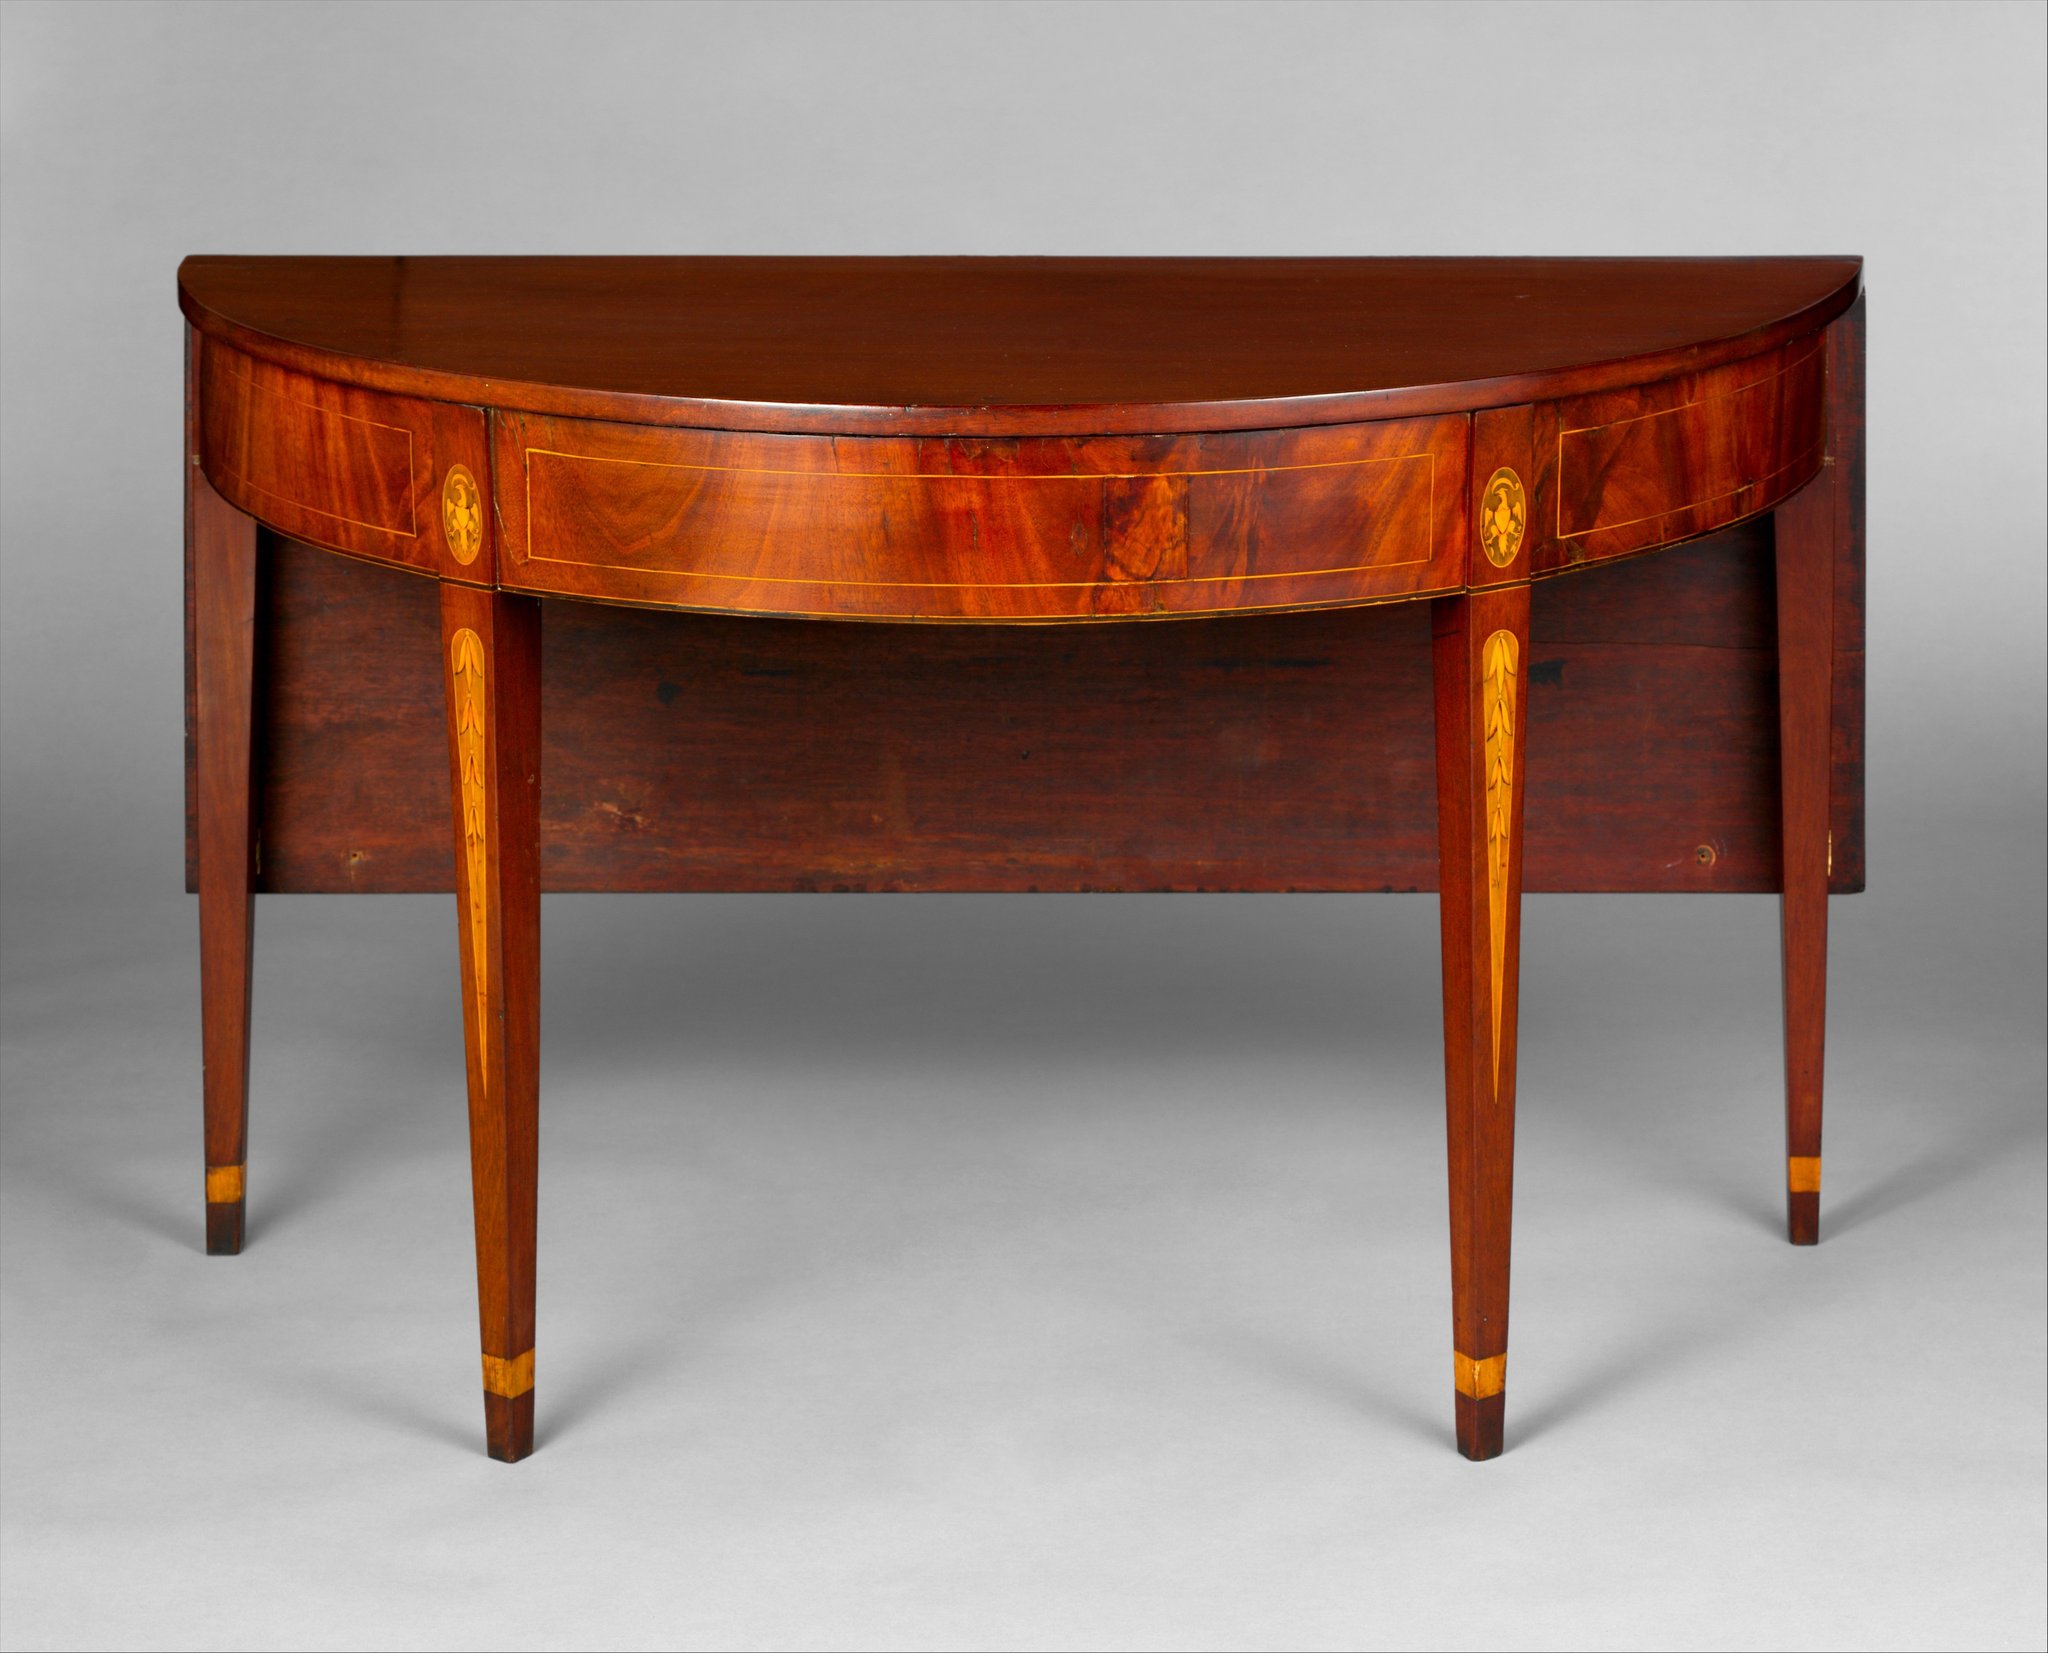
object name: drop leaf dining table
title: Drop-leaf dining table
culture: american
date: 1795-1810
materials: wood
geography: united states